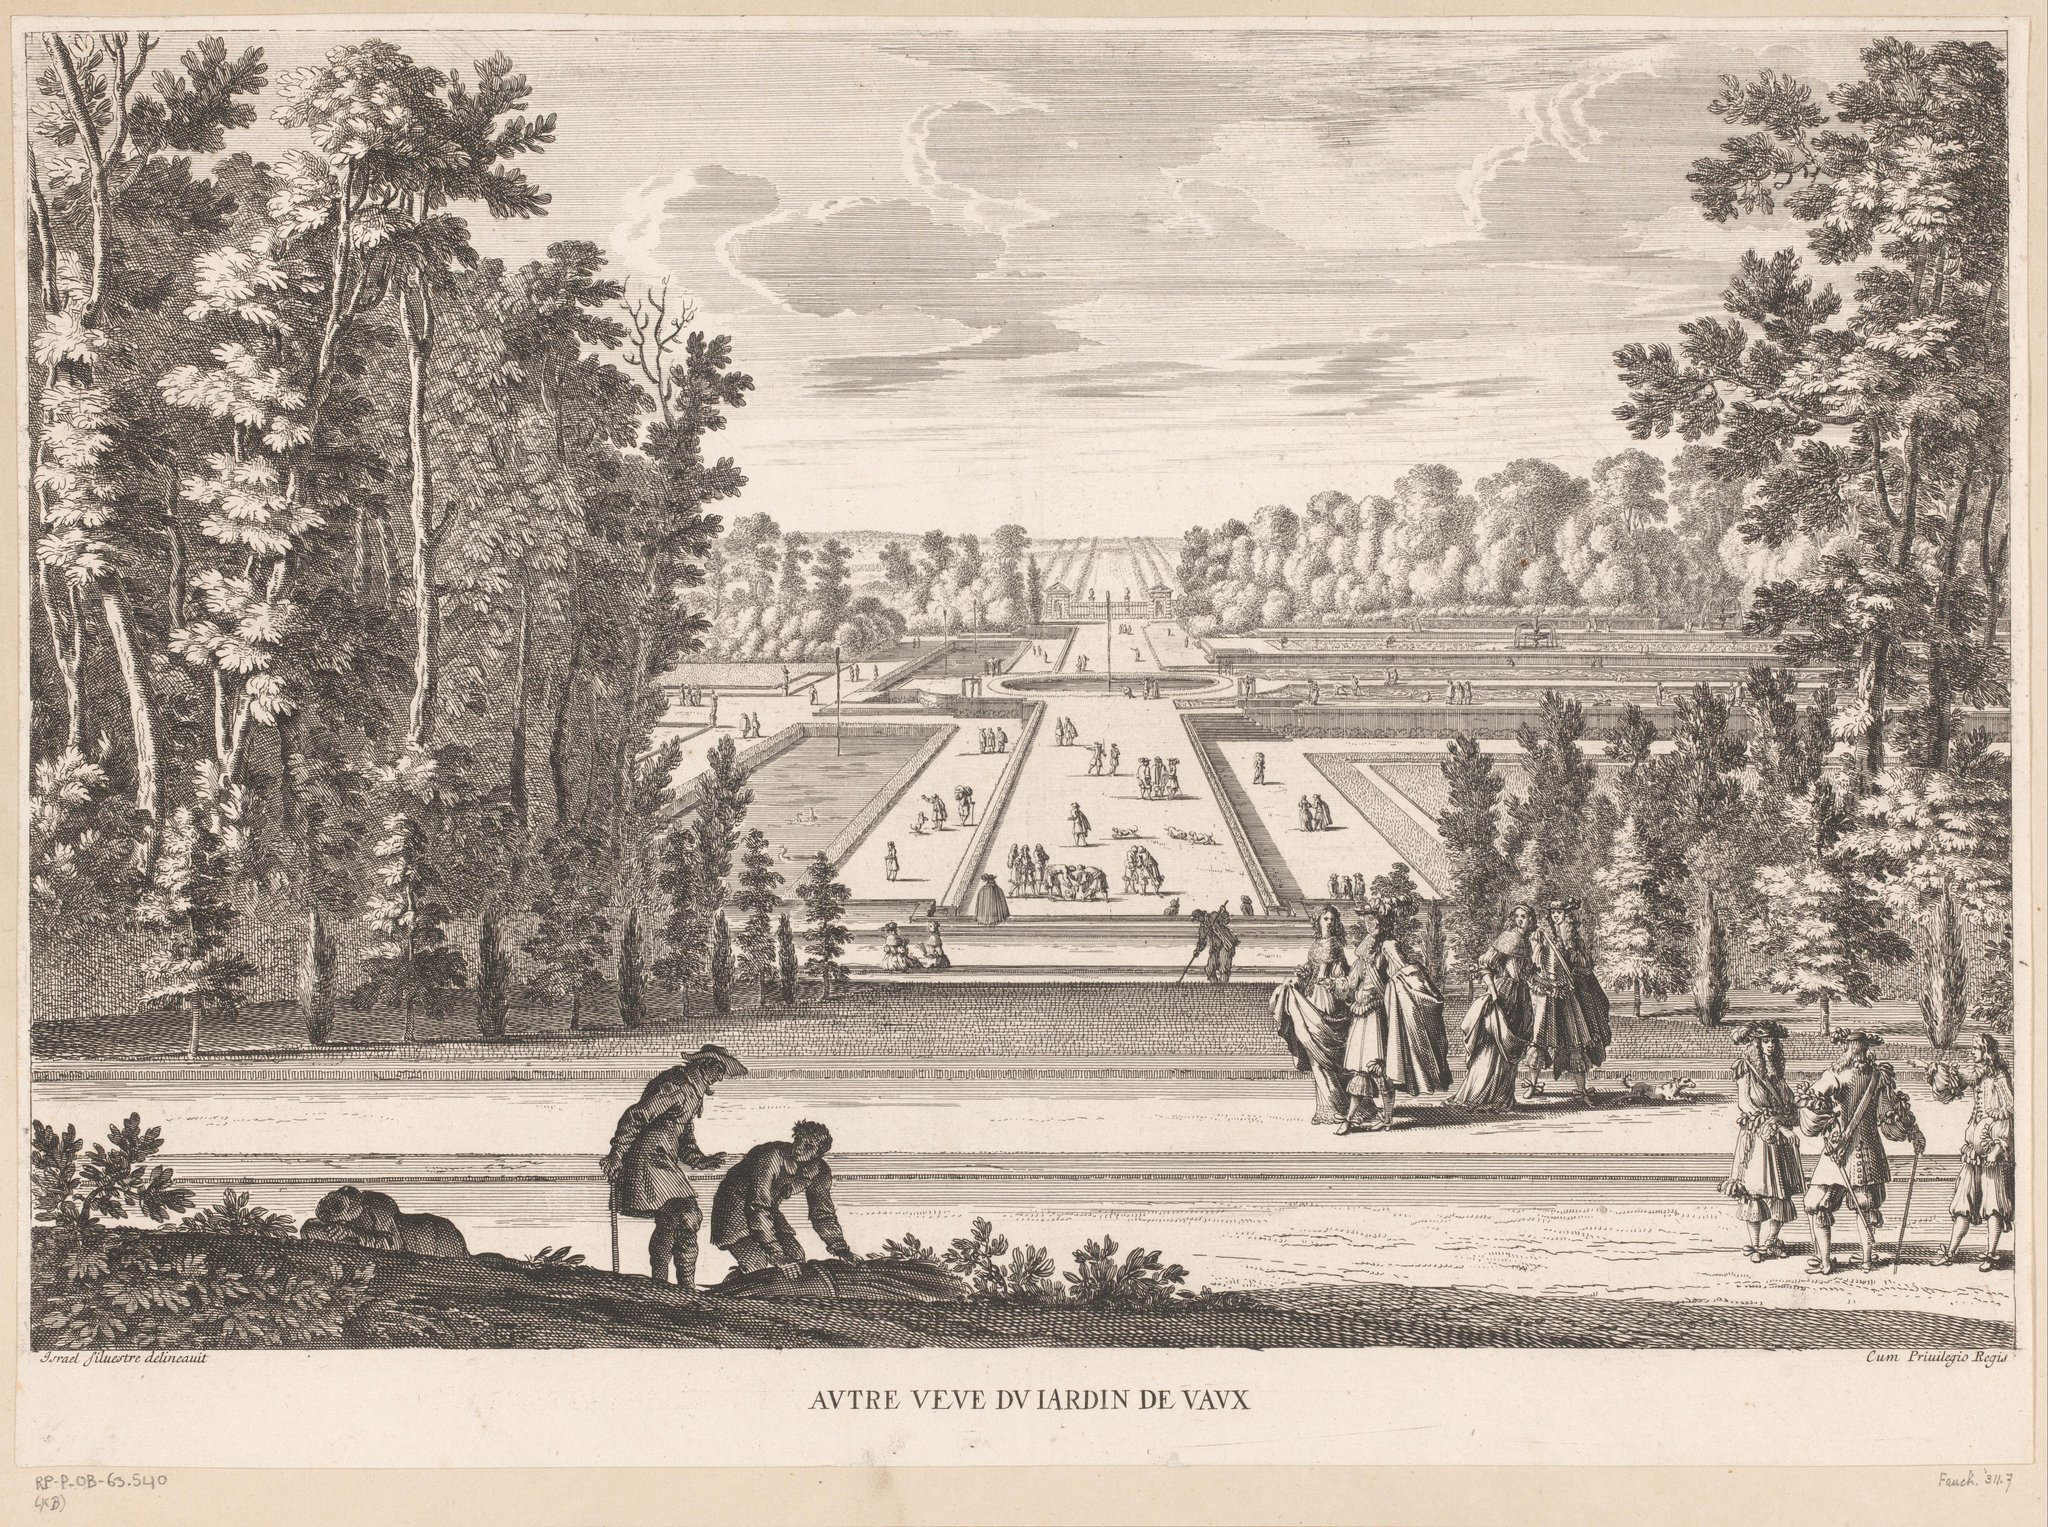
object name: print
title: Autre Veue du Jardin de Vaux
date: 1631-1691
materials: paper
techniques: engraving, etching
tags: french or architectonic garden; formal garden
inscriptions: collector's mark: Lugt 240